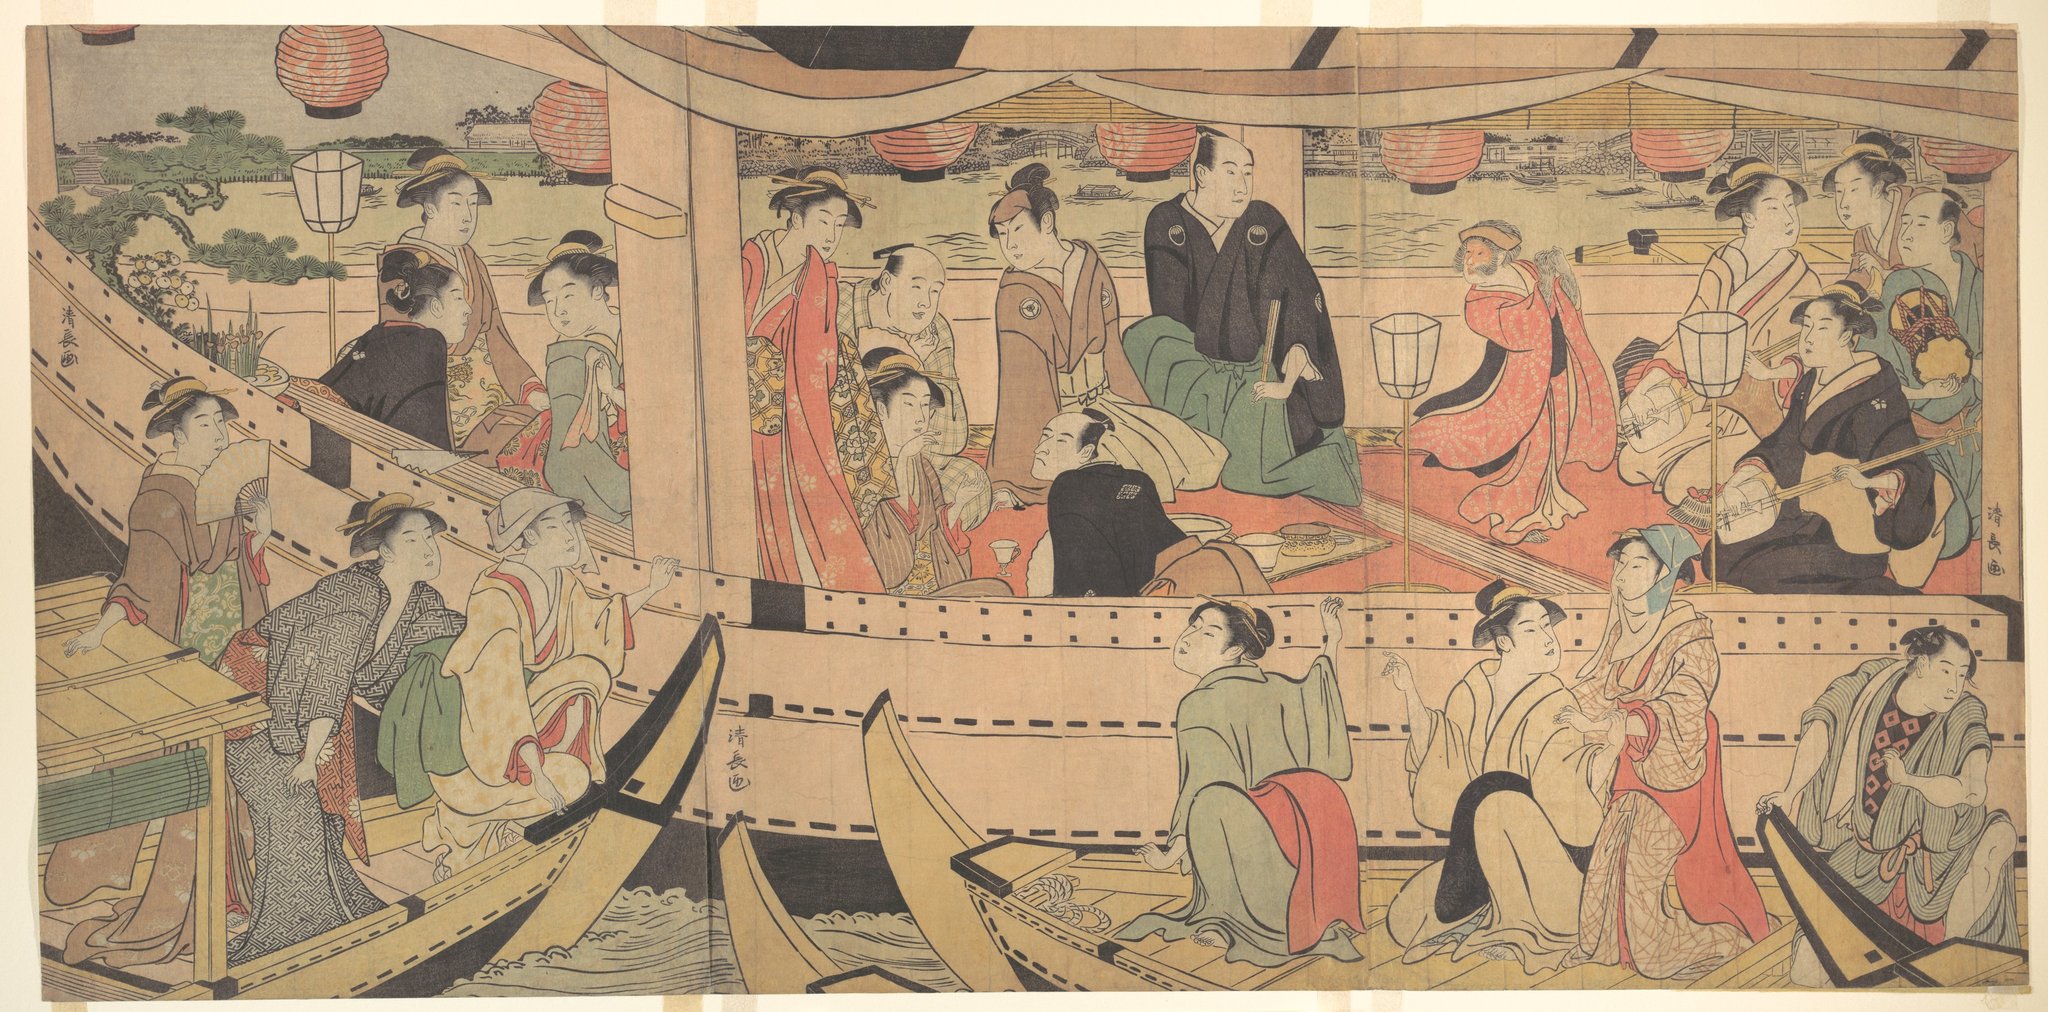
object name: print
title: Sumida River Holiday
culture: japanese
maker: torii kiyonaga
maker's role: artist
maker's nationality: japanese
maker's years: 1752-1815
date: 1788-1790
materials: ink, paper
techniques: woodblock print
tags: men,women,rivers,boats